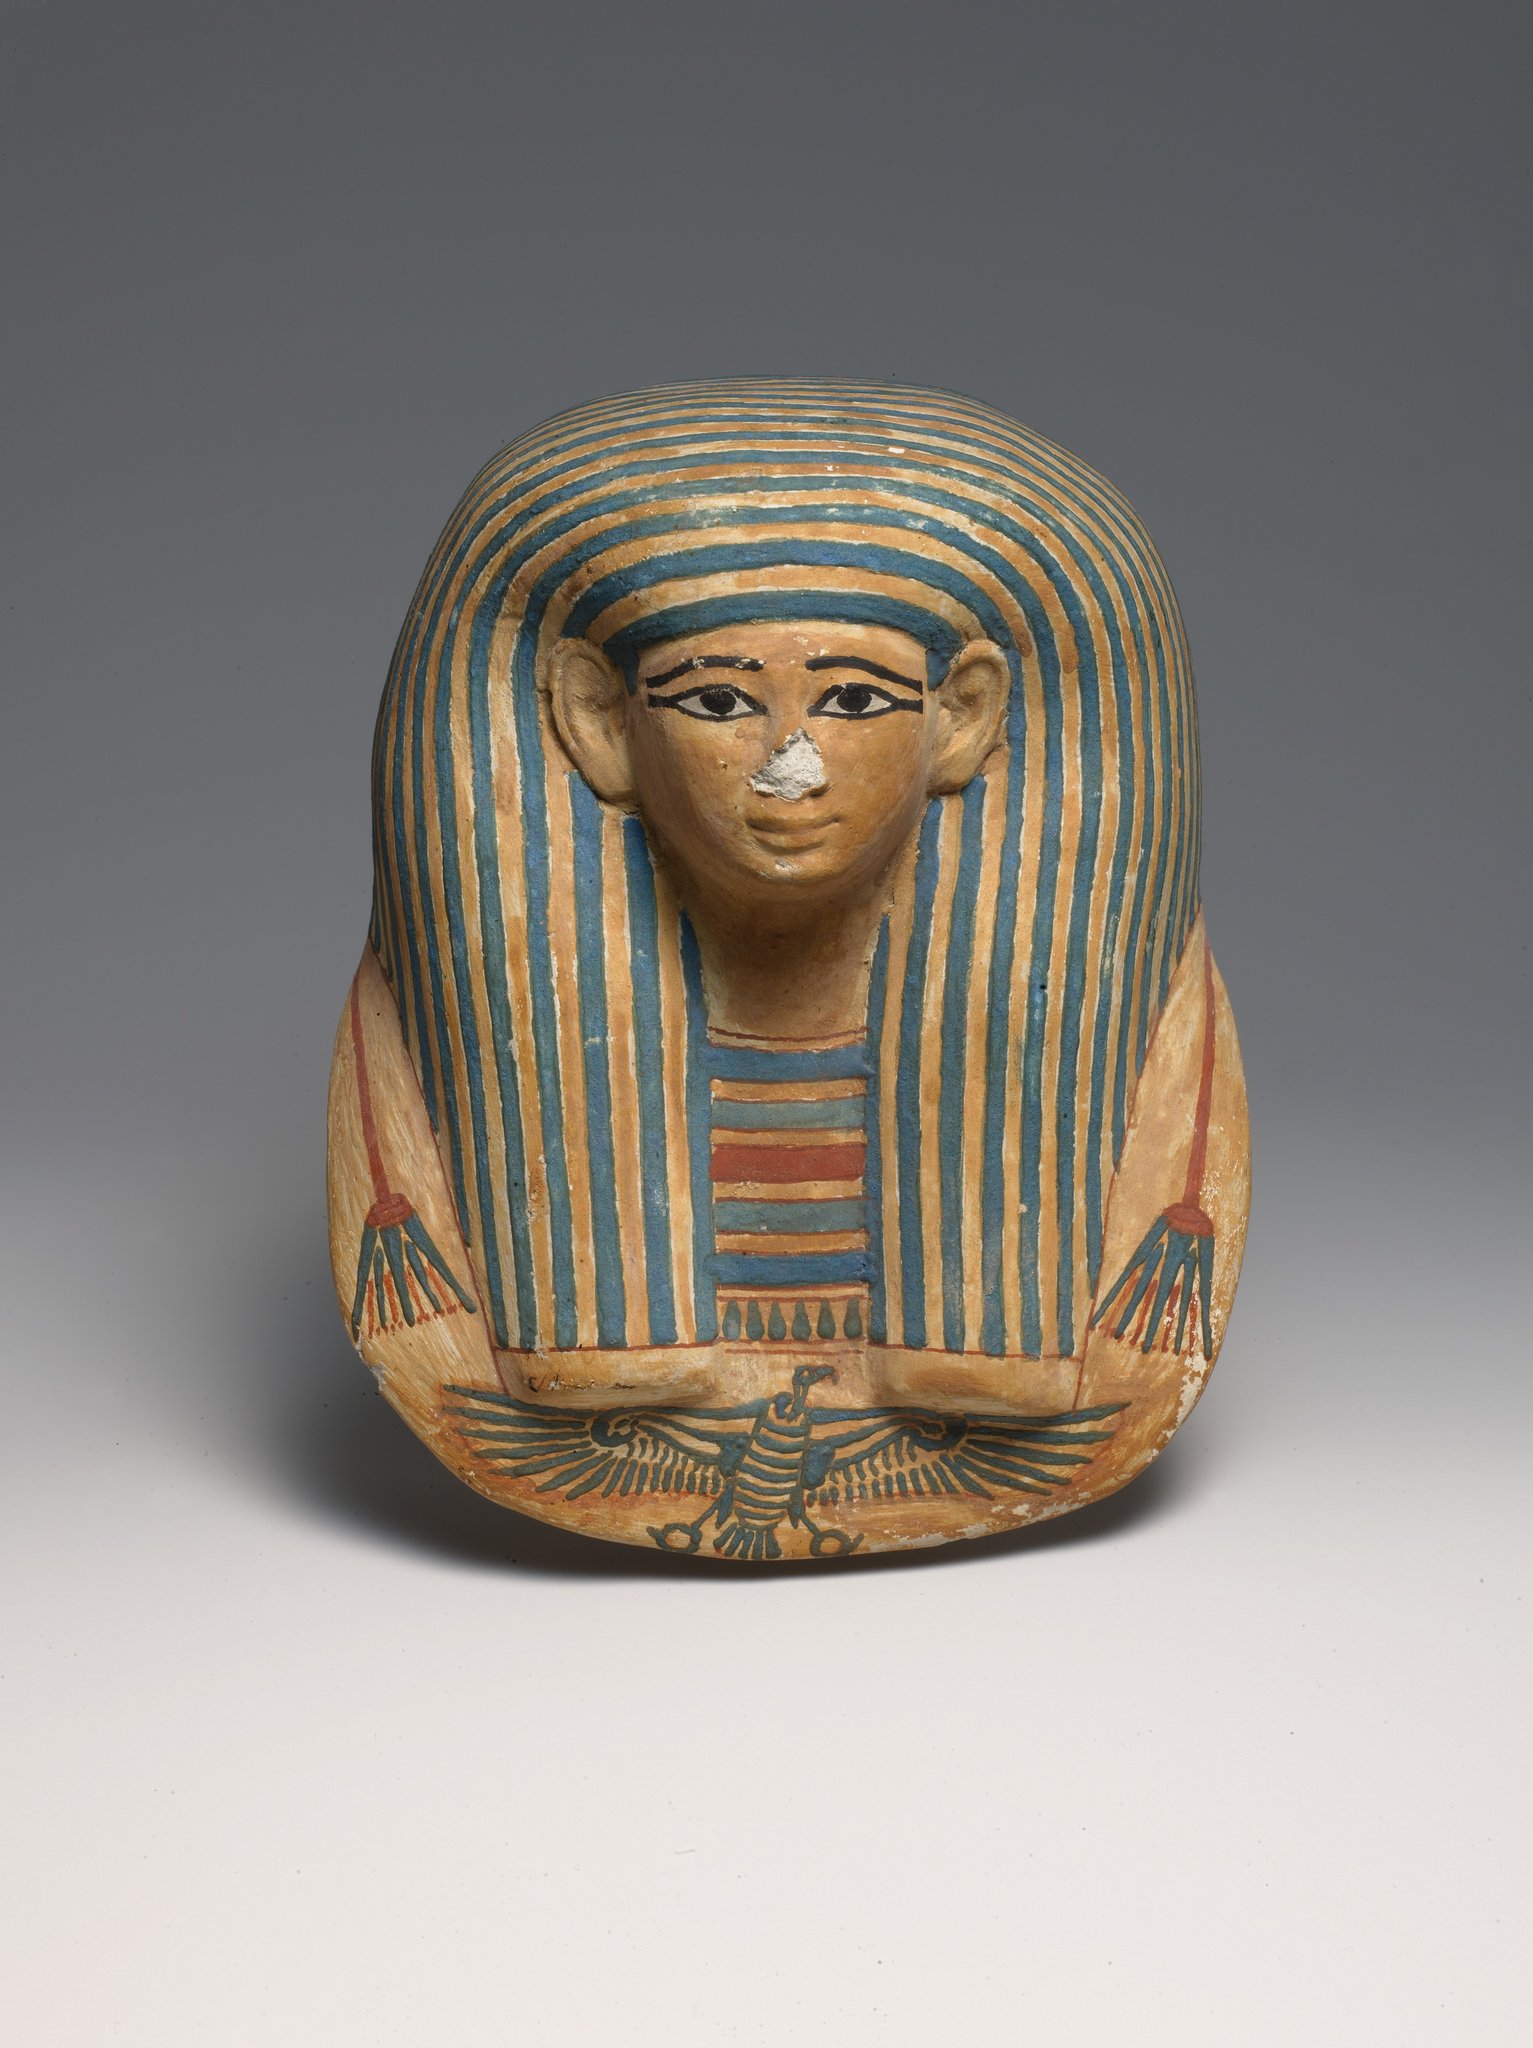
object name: mask, canopic bundle, miniature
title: Miniature Mask for a Canopic bundle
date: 1427-1400 BCE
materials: paint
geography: egypt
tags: masks